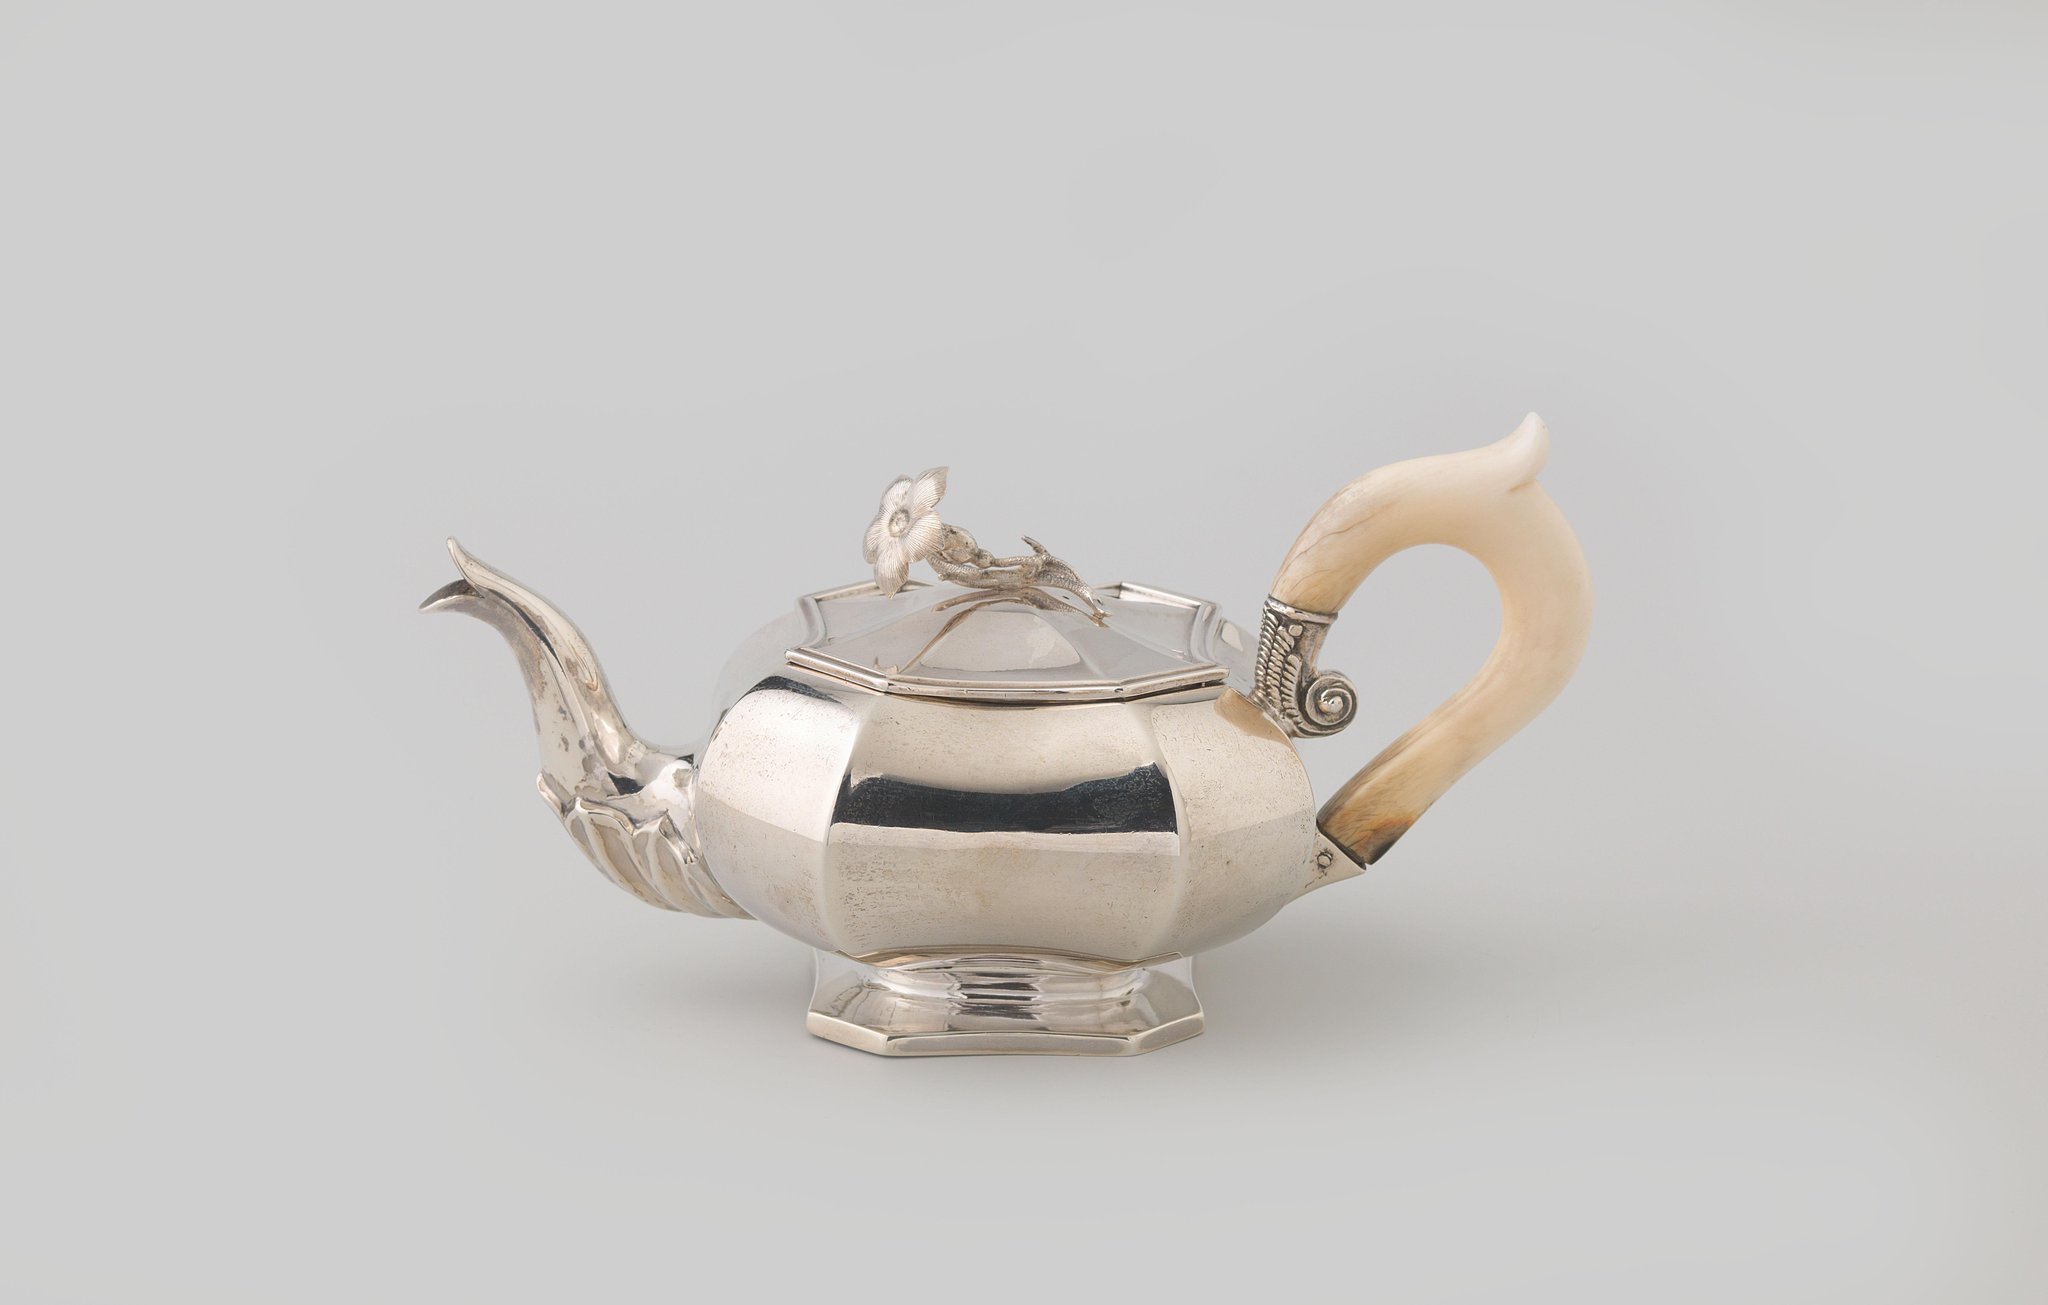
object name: teapot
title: Trekpot, achtkantig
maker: jacob helweg (ii)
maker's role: silversmith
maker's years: 1798-1875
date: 1854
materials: ivory, silver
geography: amsterdam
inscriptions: assayer's mark, alloy mark, maker's mark, maker's mark, date letter: ‘U’, assay office mark, retailer's mark: ‘BONEBAKKER EN ZOON’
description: Teapot and milk jug. Silver, ivory teapot handle. Amsterdam, Bonebakker & Zoon, 1853 - 1854, by Theodorus Gerardus Bentvelt. The teapot was made for Freule Johanna Petronella Catharina van Reede van Outshoorn (1815 - 1883). Mrs A.J. Jordens-Sweerts de Landas bequest, 1952.